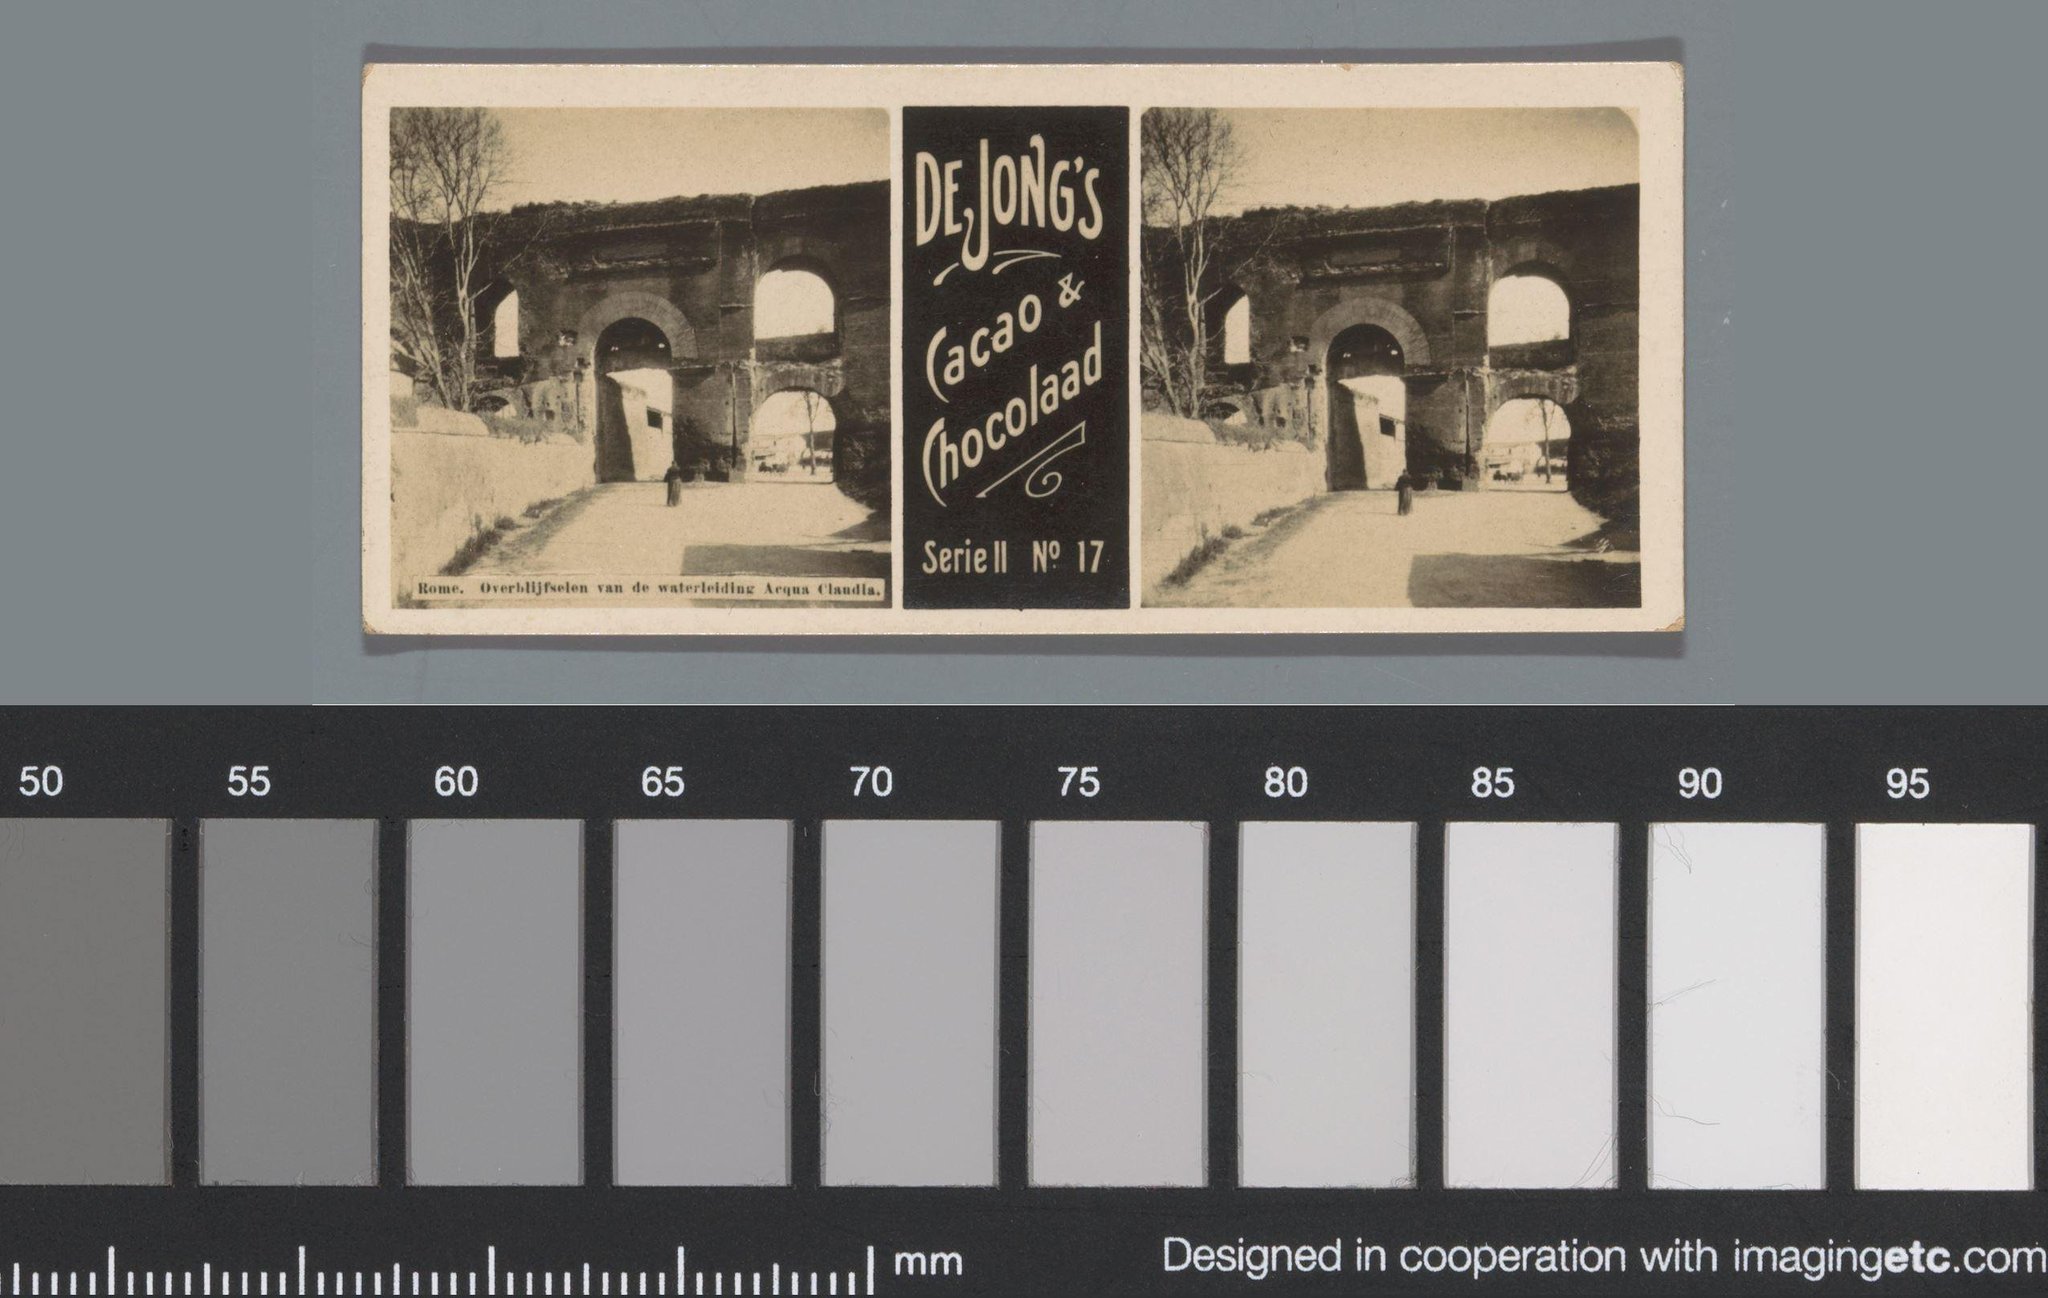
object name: stereograph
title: Ruïne van de Aqua Claudia te Rome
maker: Anonymous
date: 1900-1910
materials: cardboard, photographic support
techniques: gelatin silver print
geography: rome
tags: aqueduct (~ water supply)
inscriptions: number: ‘Serie II No 17’, inscription: ‘De Jong's Cacao & Chocolaad’